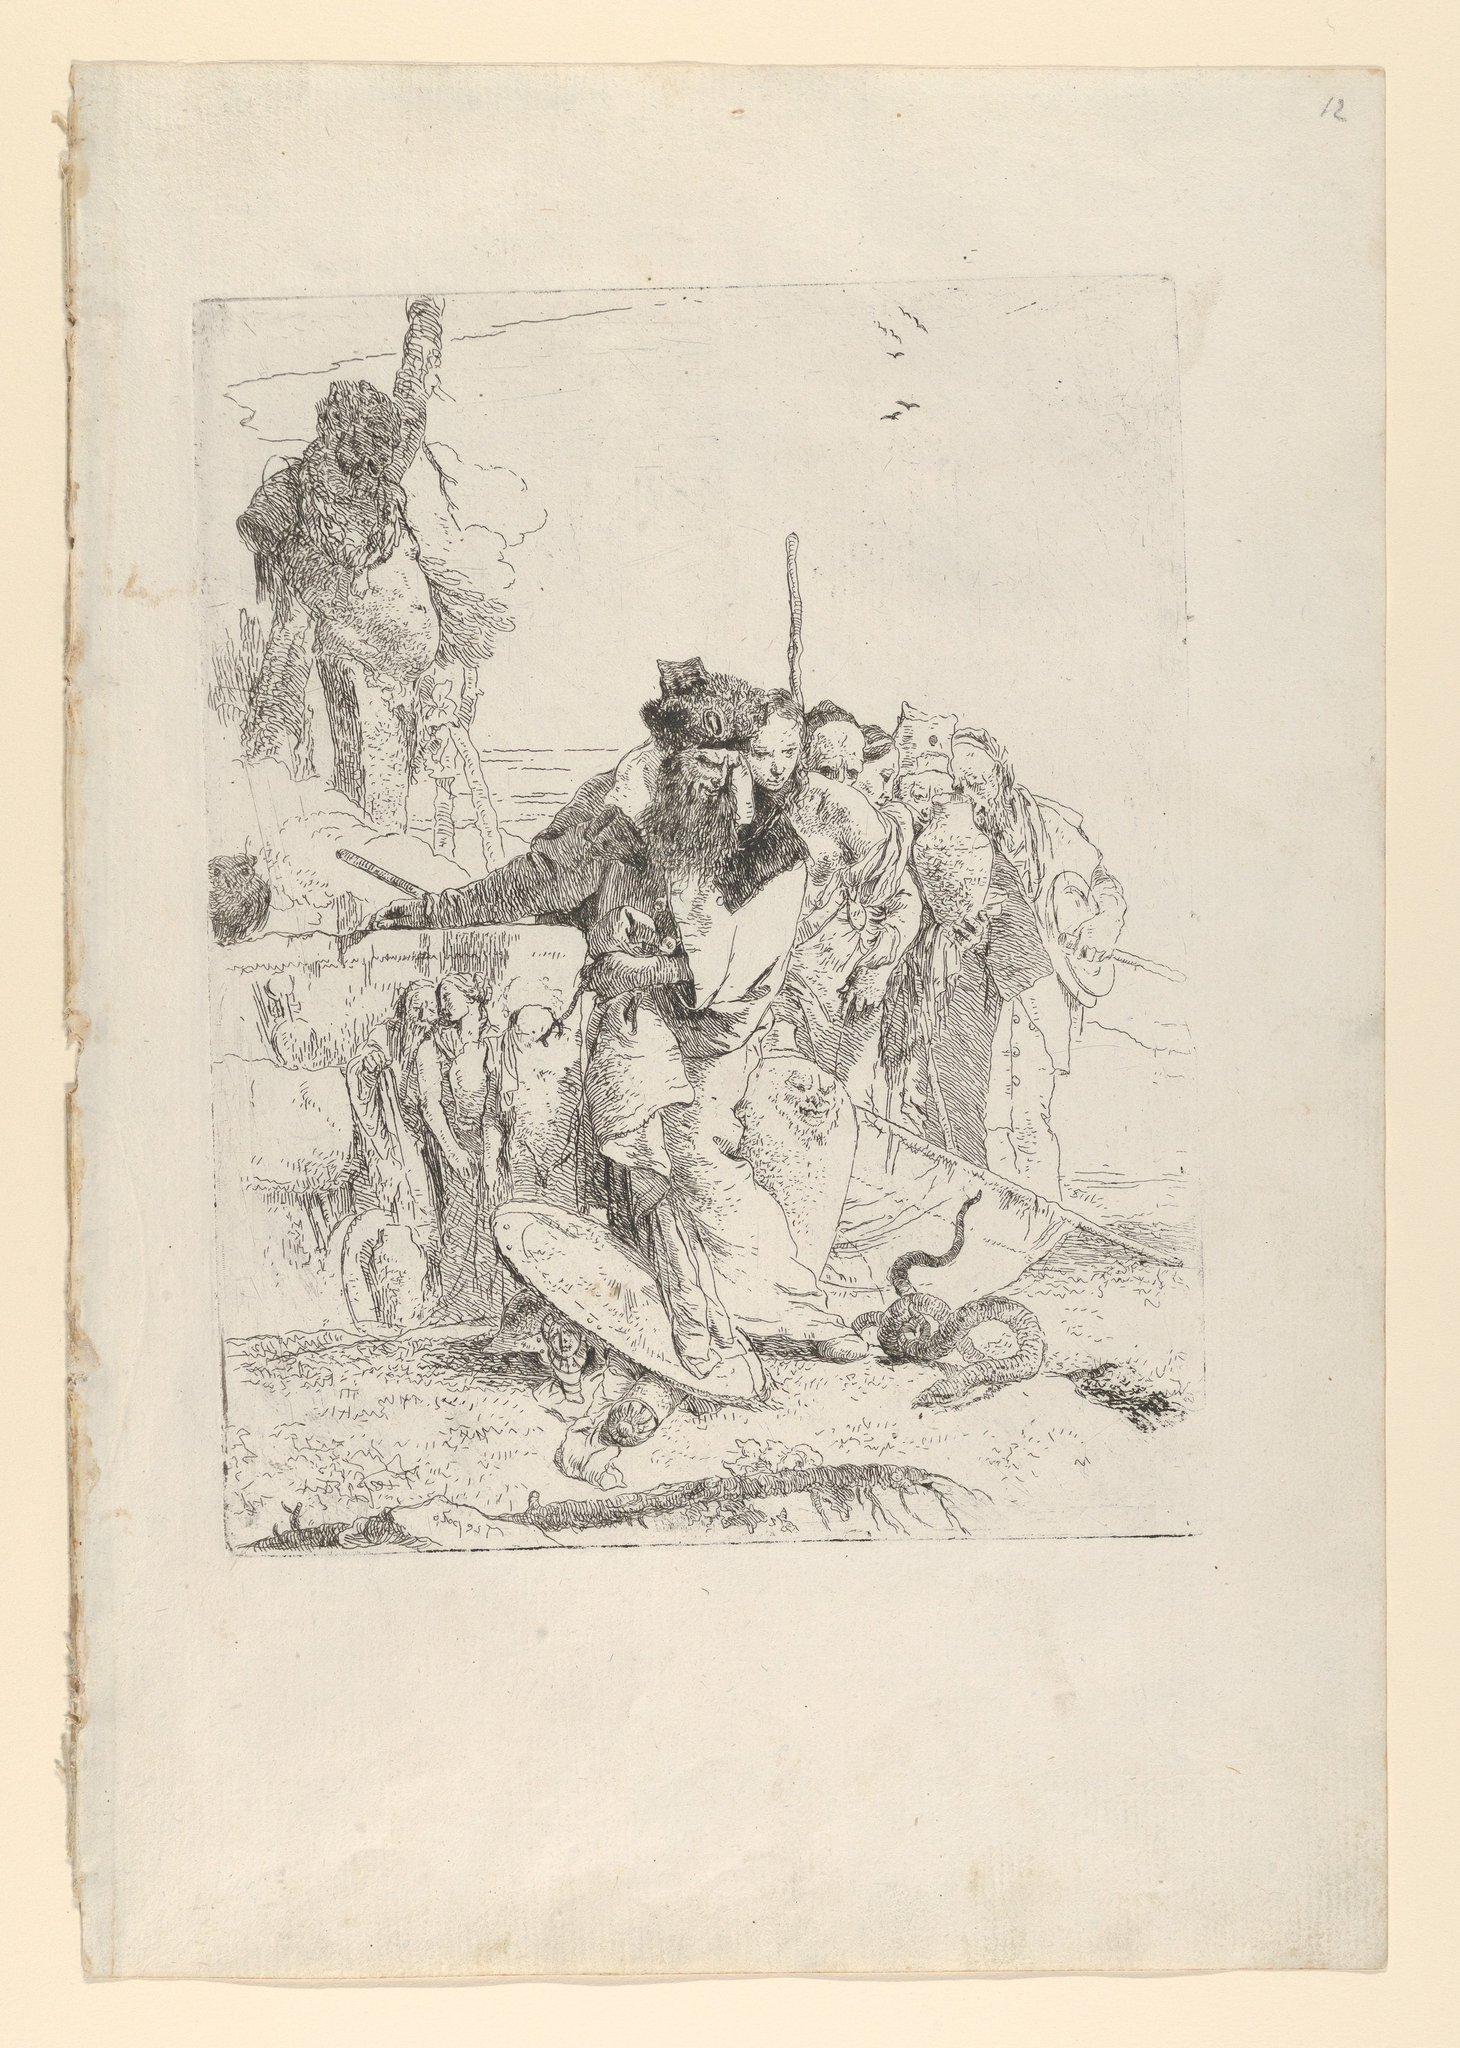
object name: print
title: Six people watching a snake, from the Scherzi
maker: giovanni battista tiepolo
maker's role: artist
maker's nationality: italian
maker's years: 1696-1770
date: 1743-1750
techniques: etching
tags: men,women,snakes